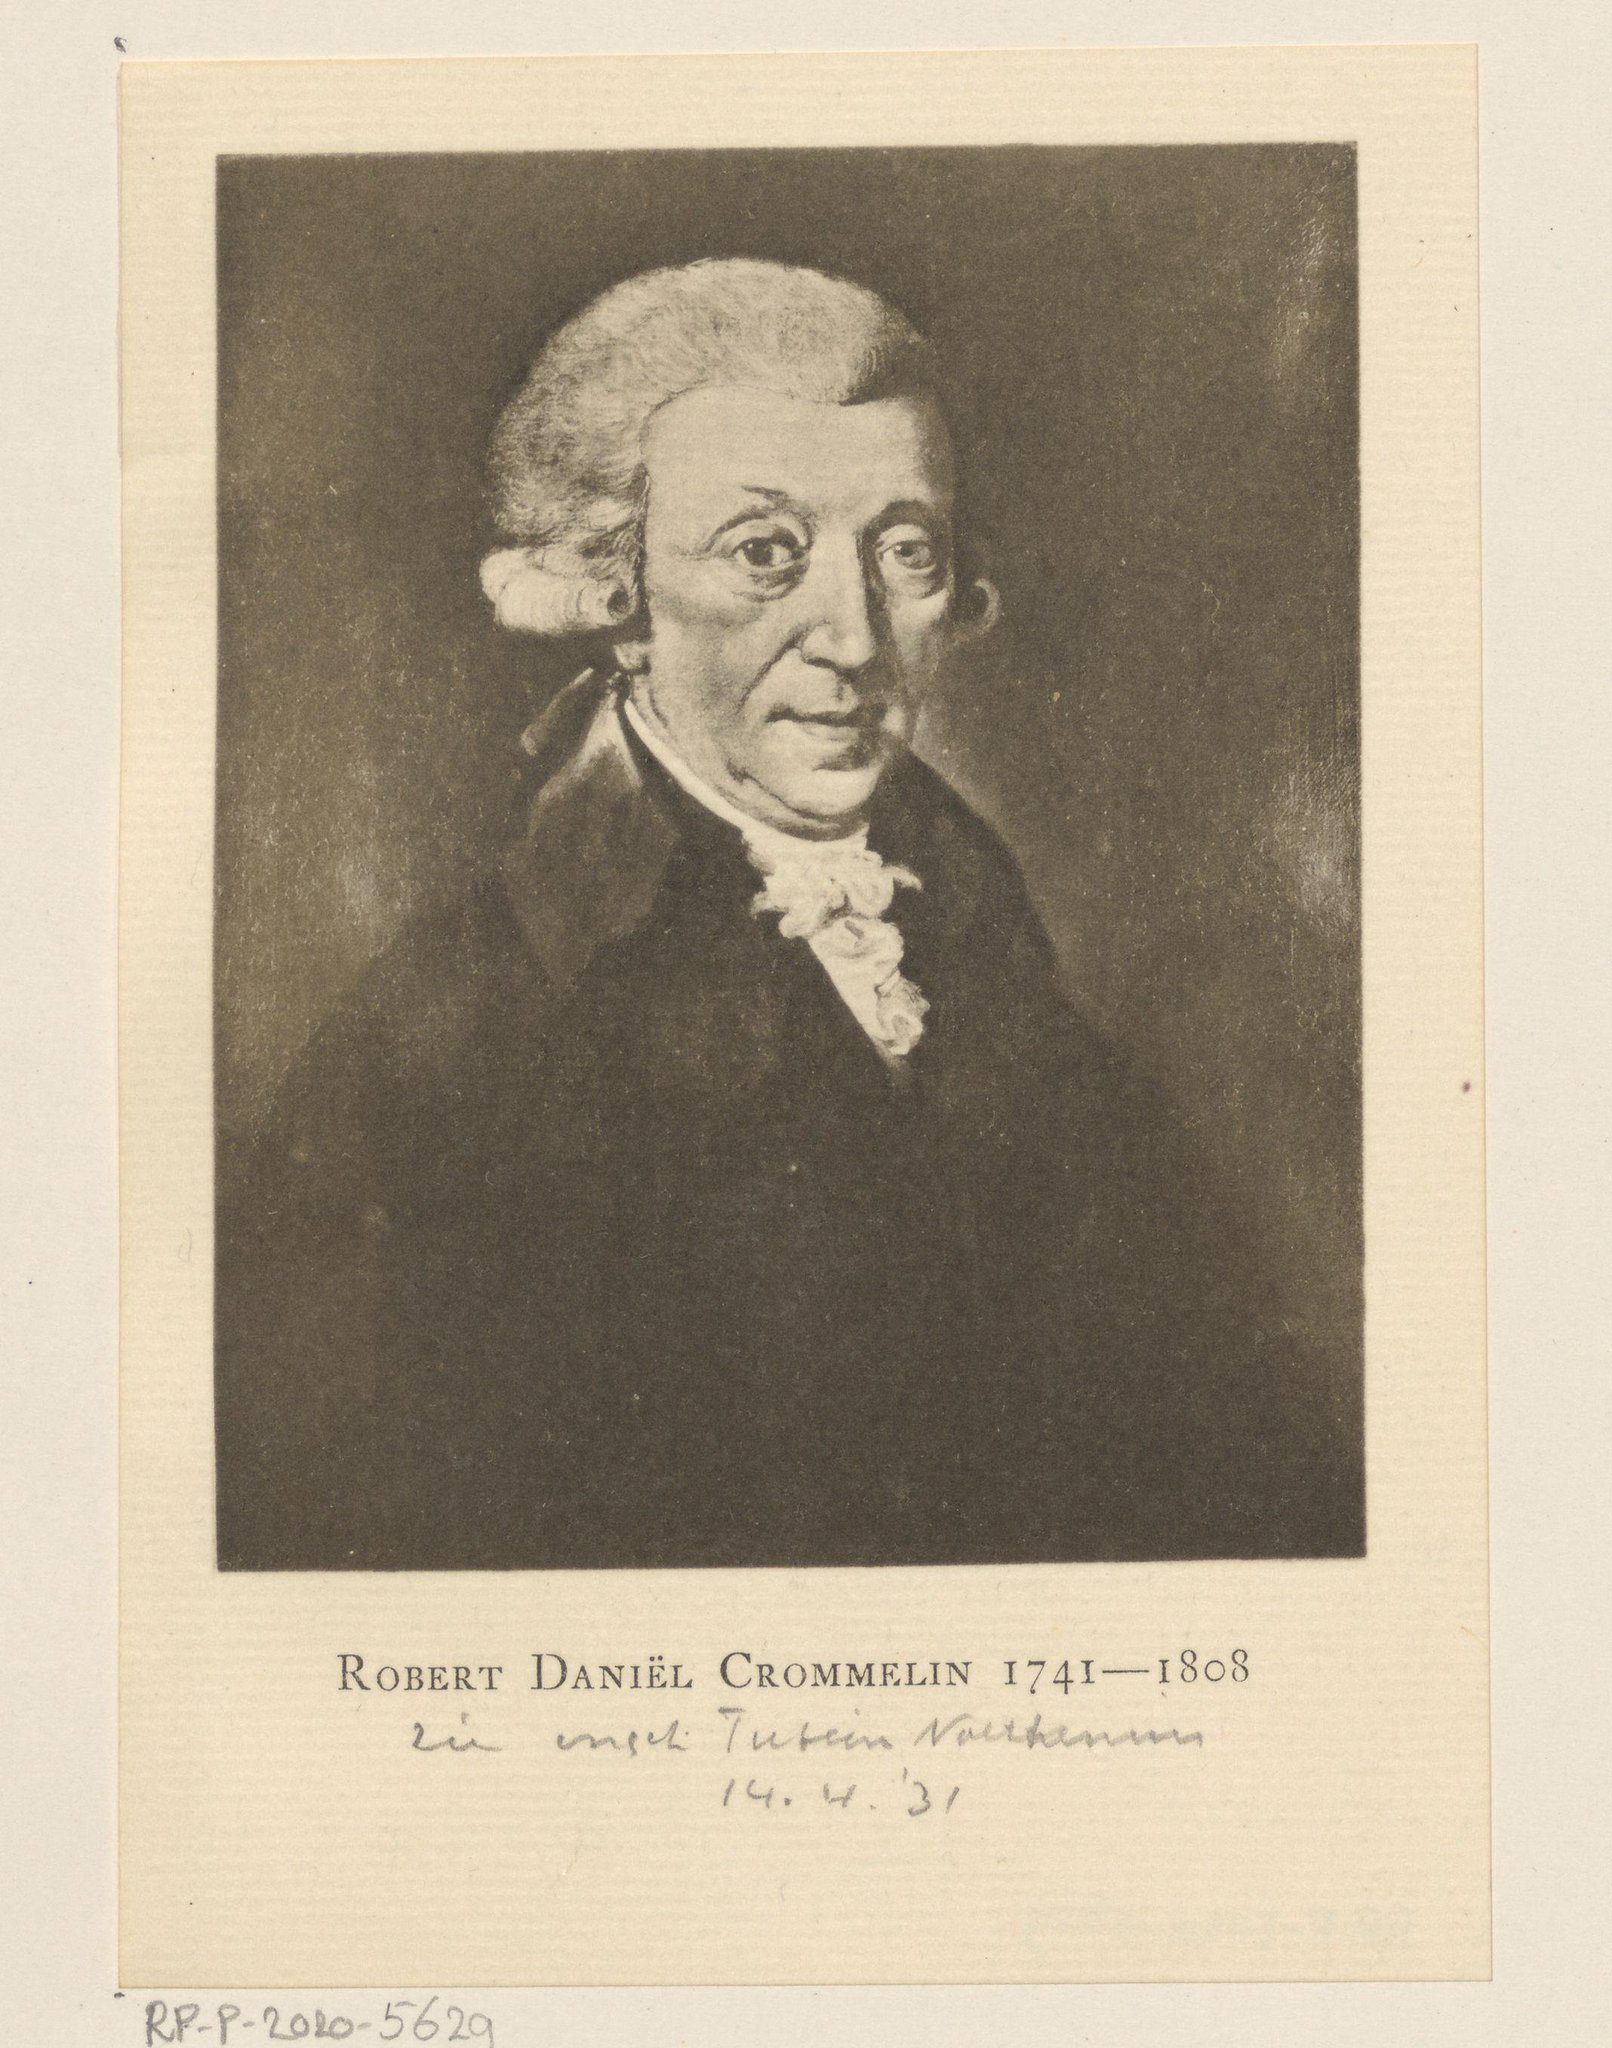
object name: photomechanical print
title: Portret van Robert Daniel Crommelin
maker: Anonymous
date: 1875-1930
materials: paper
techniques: photograph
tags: historical persons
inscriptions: : Lugt 2228